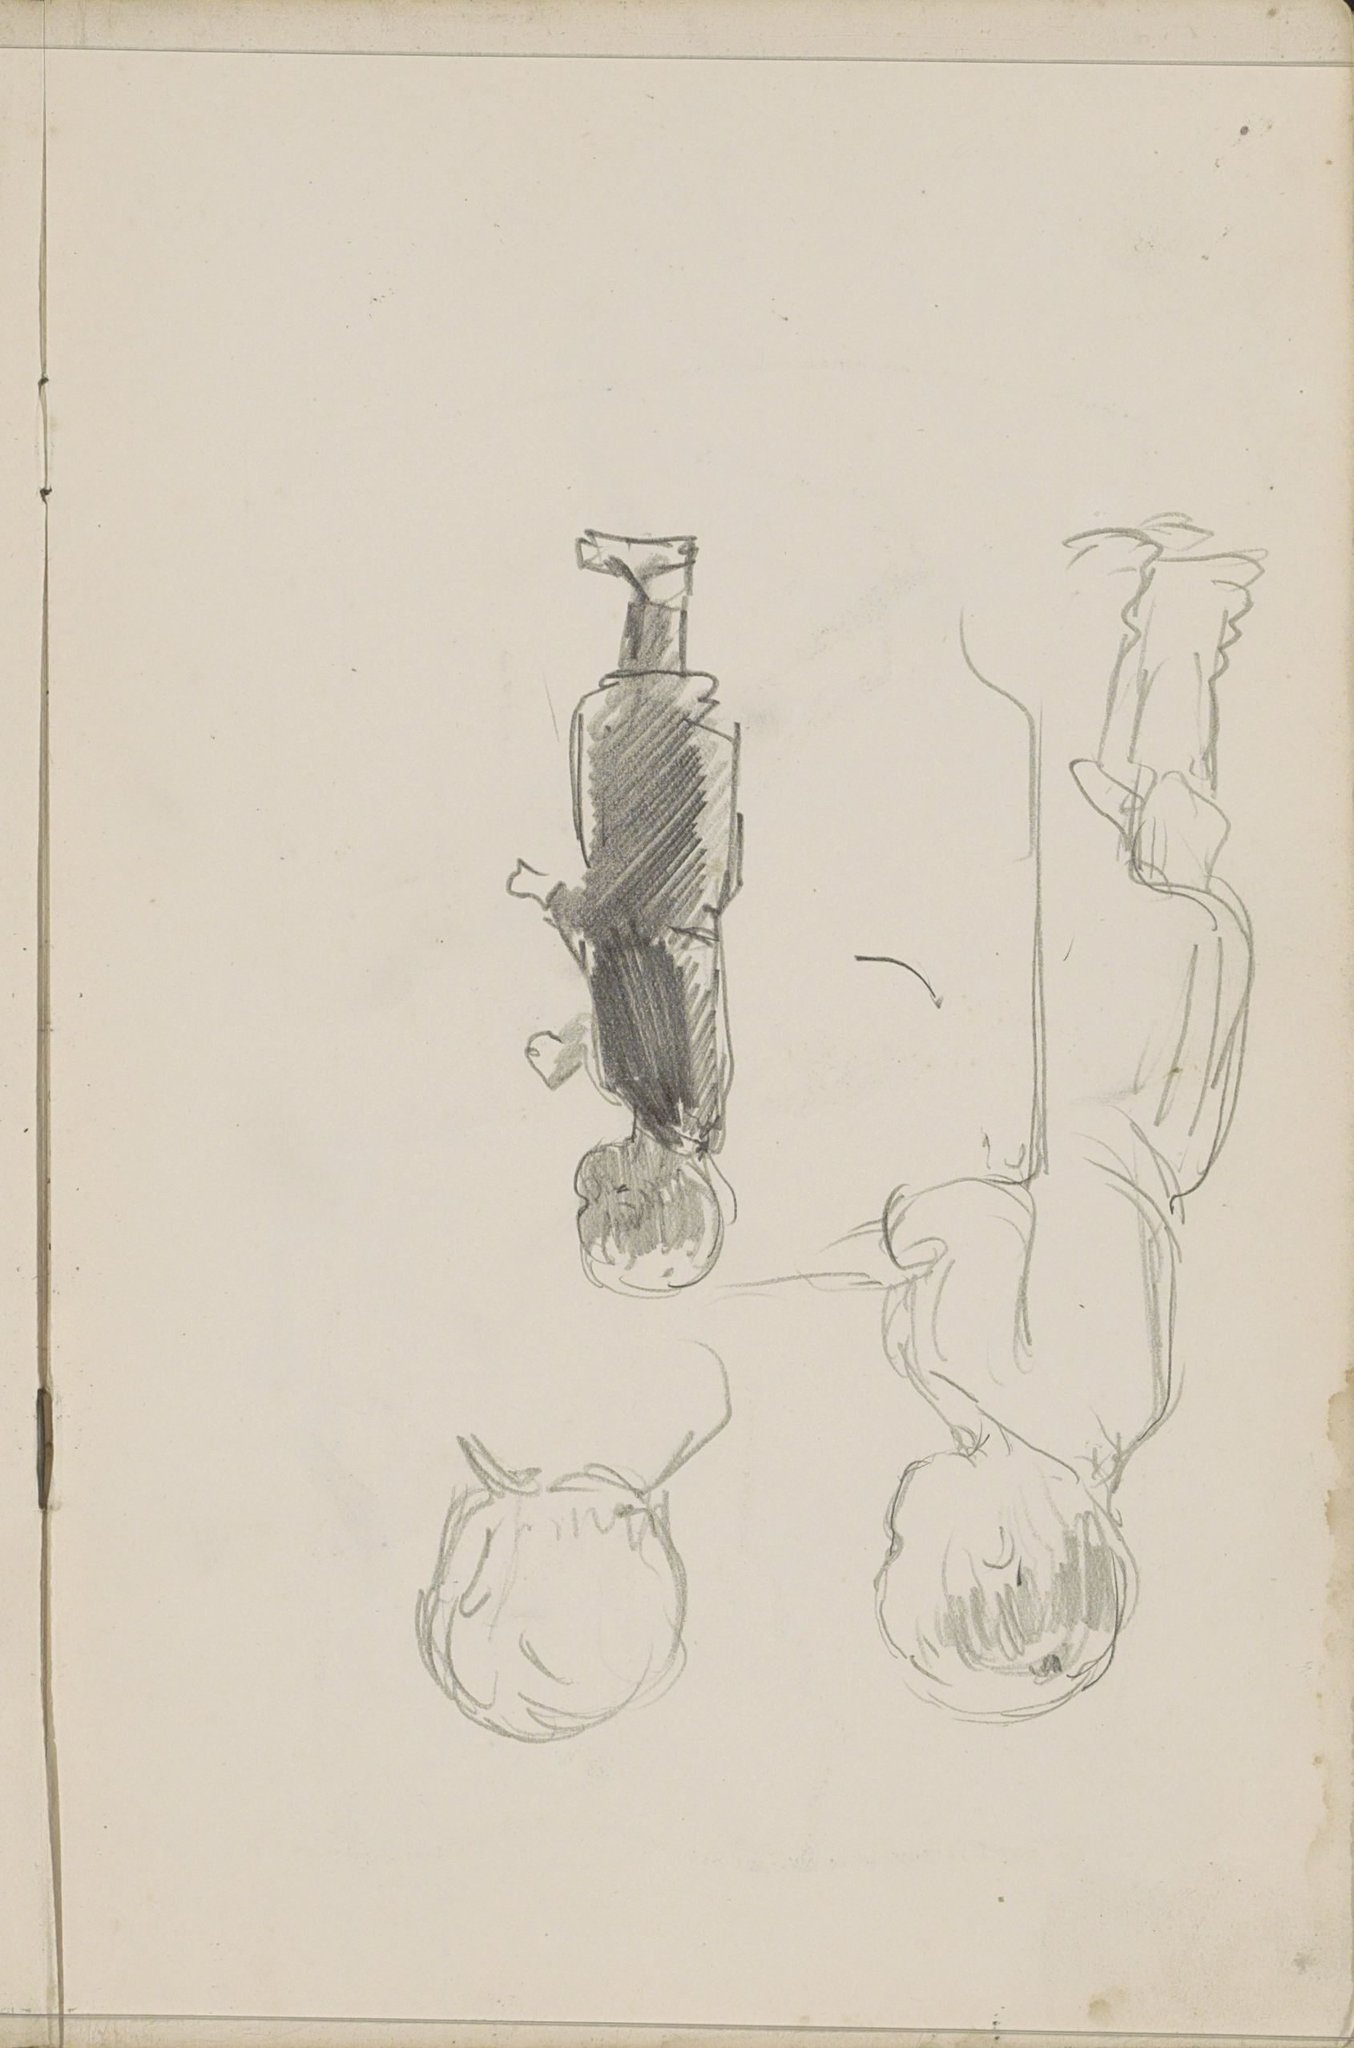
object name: sketchbook leaf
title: Staand kind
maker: cornelis vreedenburgh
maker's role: draughtsman, print maker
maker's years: 1880-1946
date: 1890-1946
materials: paper, pencil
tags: child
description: Blad 3 recto uit een schetsboek met 47 bladen.